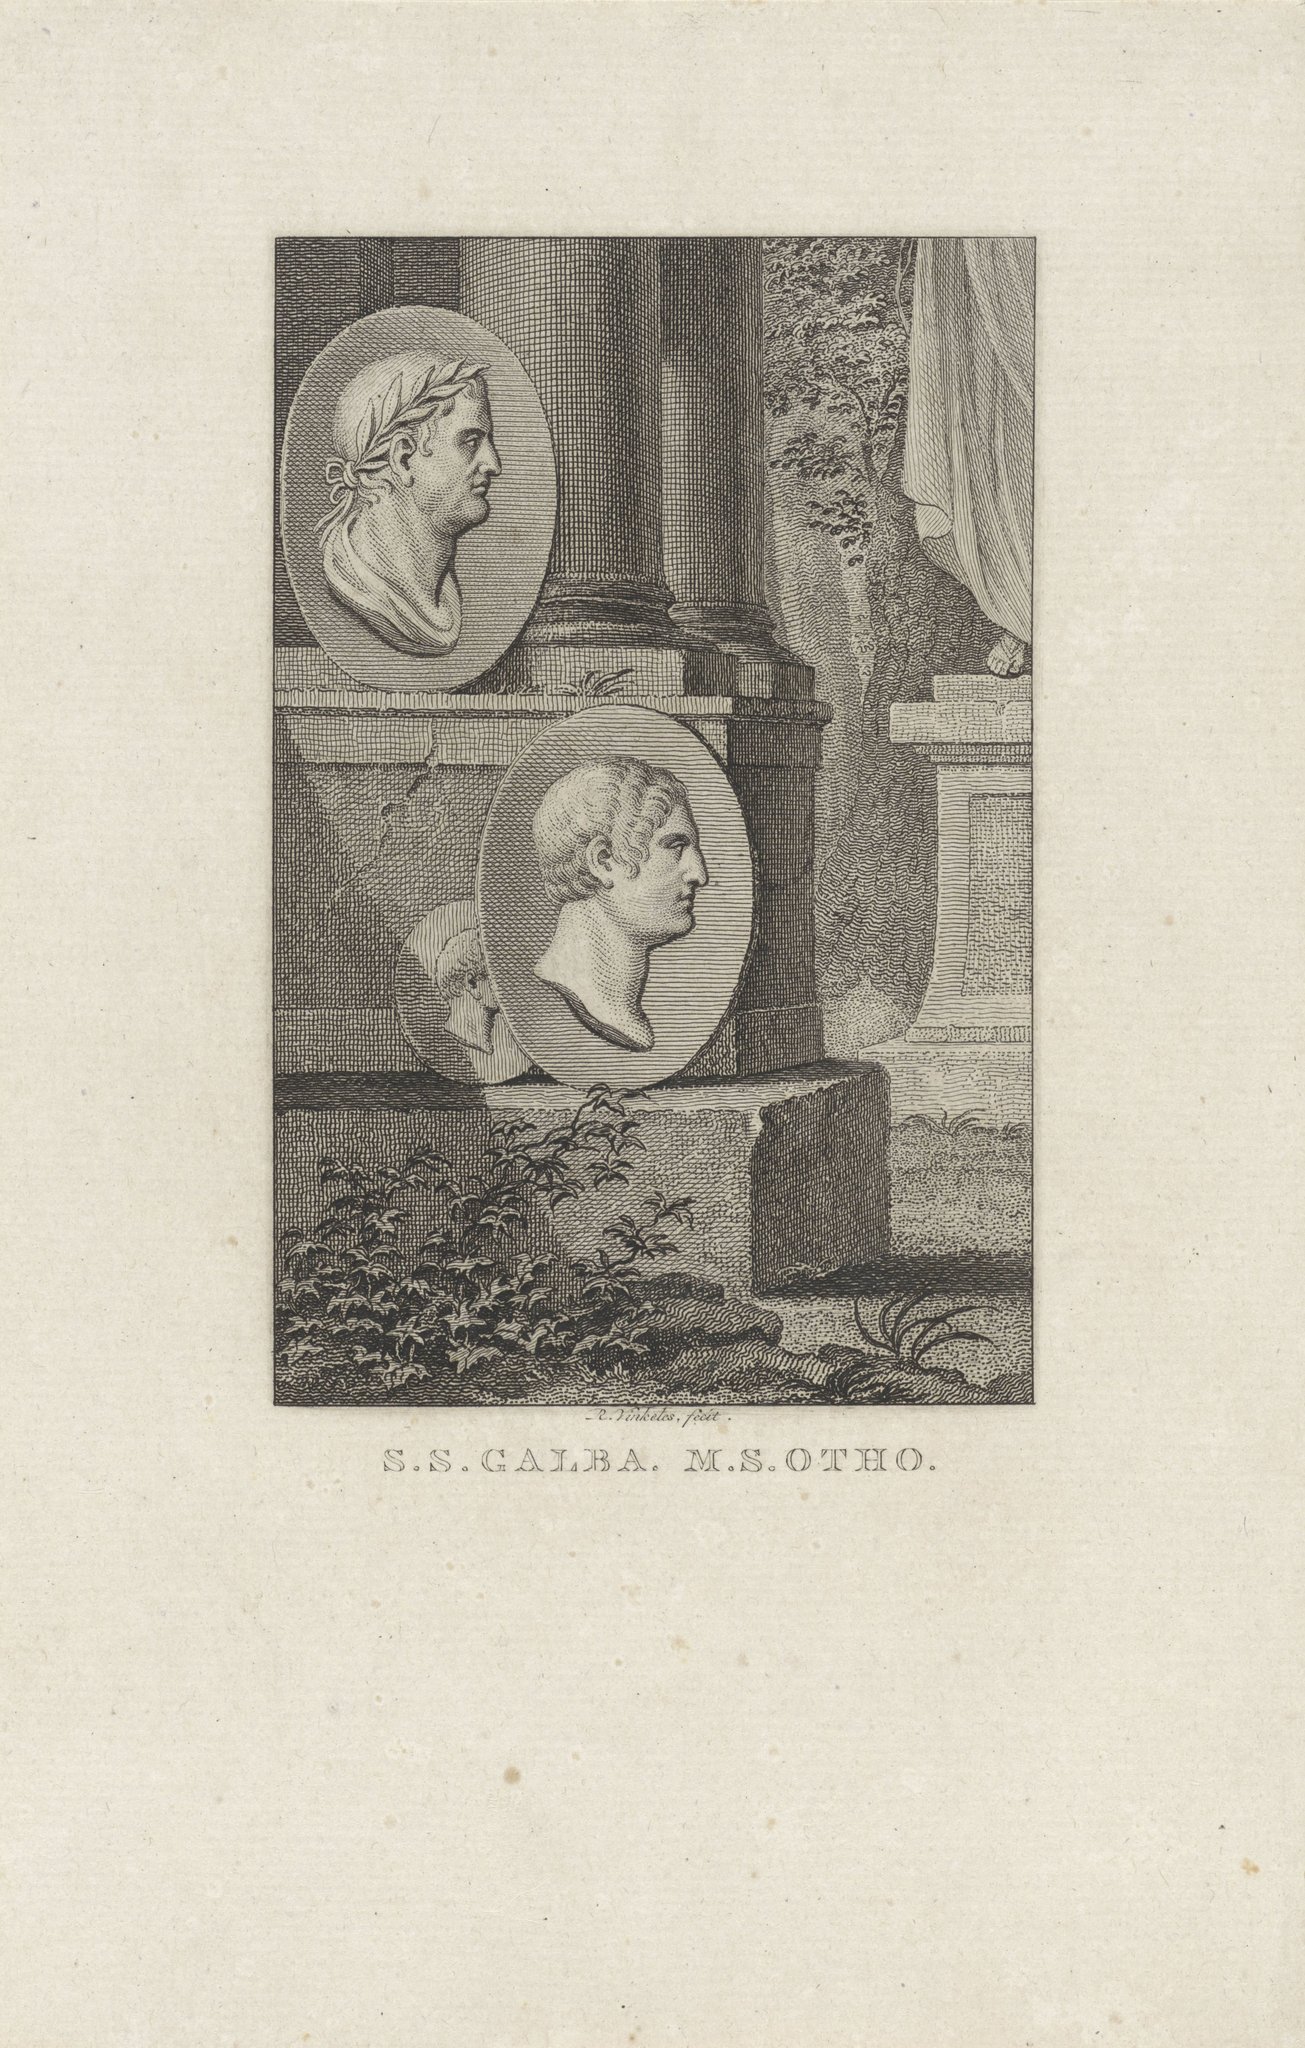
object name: print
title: Medaillons met portretten van Servius Sulpicius Galba en Marcus Salvius Otho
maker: reinier vinkeles (i)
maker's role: draughtsman, print maker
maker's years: 1741-1816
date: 1789-1809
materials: paper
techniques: etching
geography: amsterdam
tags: galba (keizer van het romeinse rijk), ferento, brescello, keizer, otho (keizer van het romeinse rijk)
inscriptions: collector's mark: Lugt 2228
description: Prent ook gebruikt als boekillustratie in: Plutarchus [bewerkt door E. Wassenbergh en H. Bosscha]. De levens van doorluchtige Grieken en Romeinen, onderling vergeleeken (...). 12 dln. Amsterdam: Johannes Allart, 1789-1809.